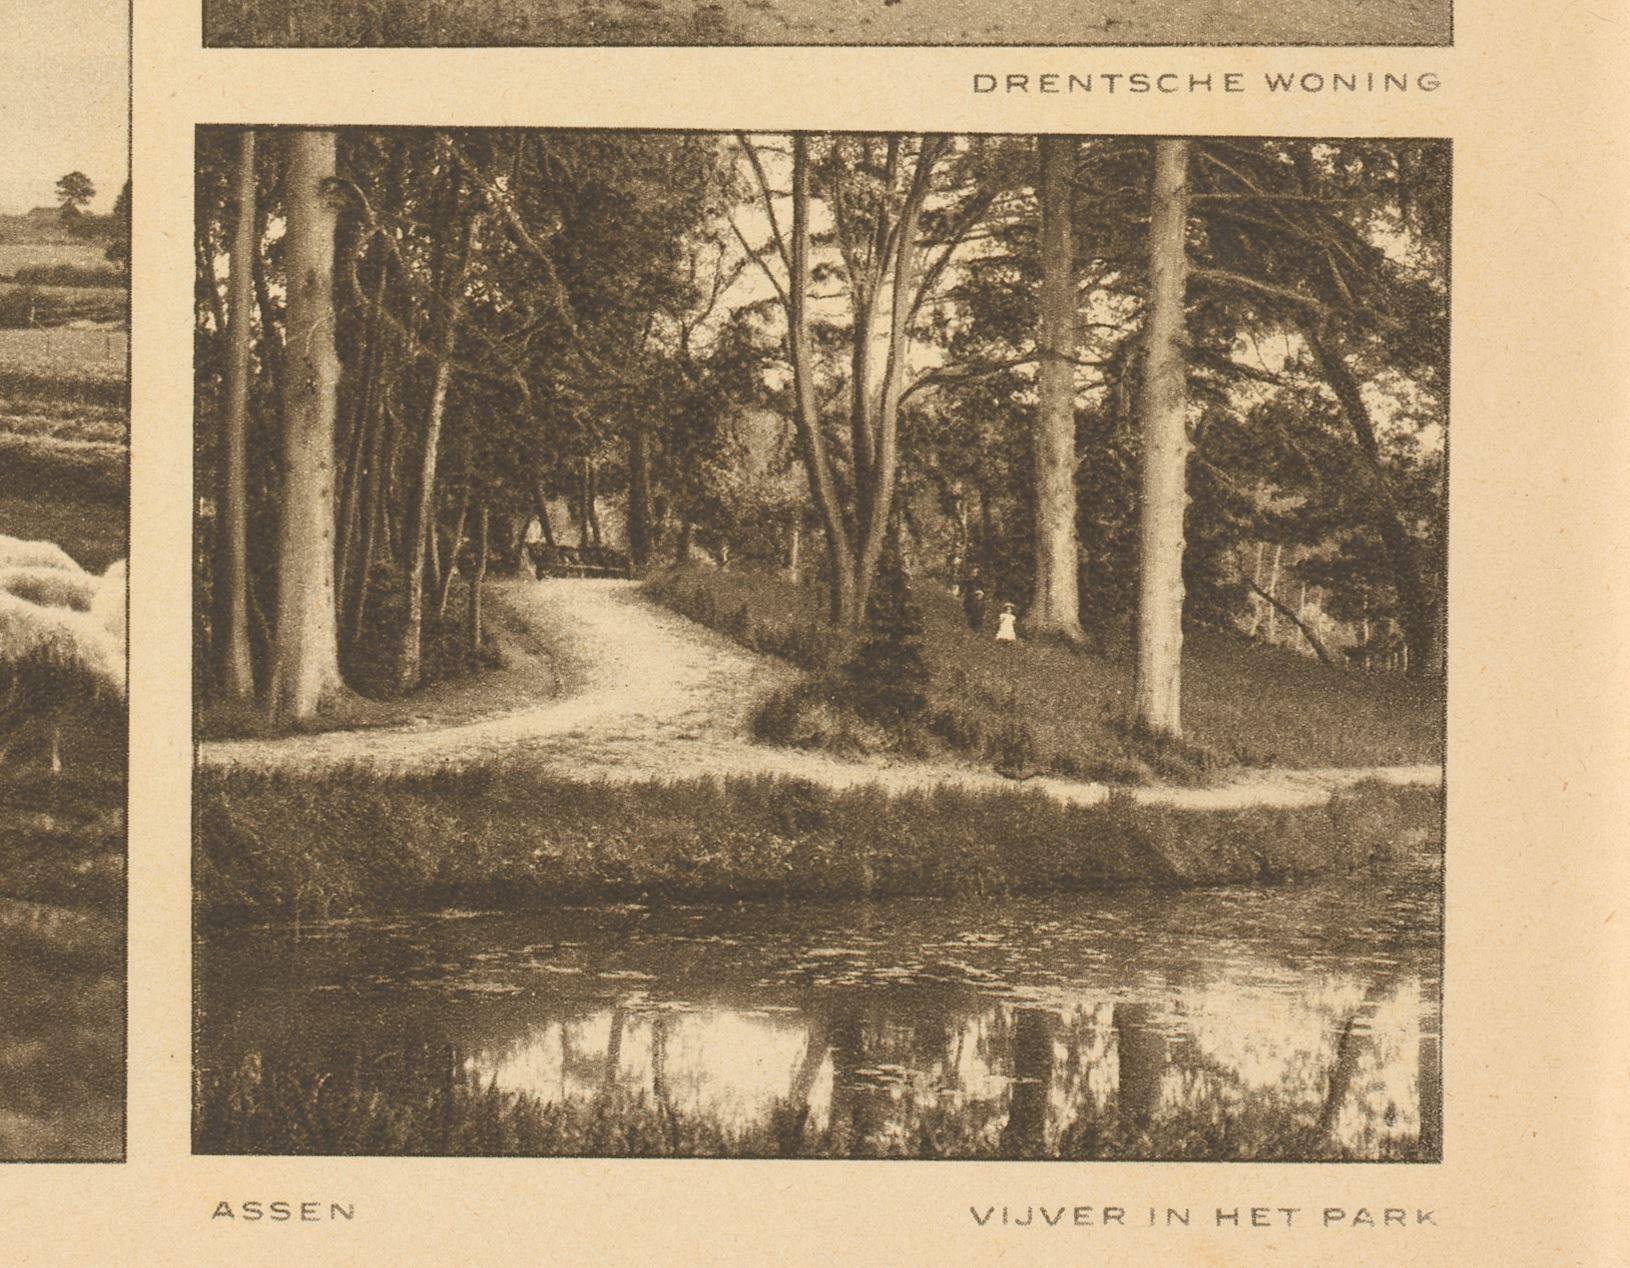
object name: album leaf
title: Assen - Vijver in het park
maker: Anonymous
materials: paper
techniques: rotogravure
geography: assen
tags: park, pond, pool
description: Deze prent maakt deel uit van een album.